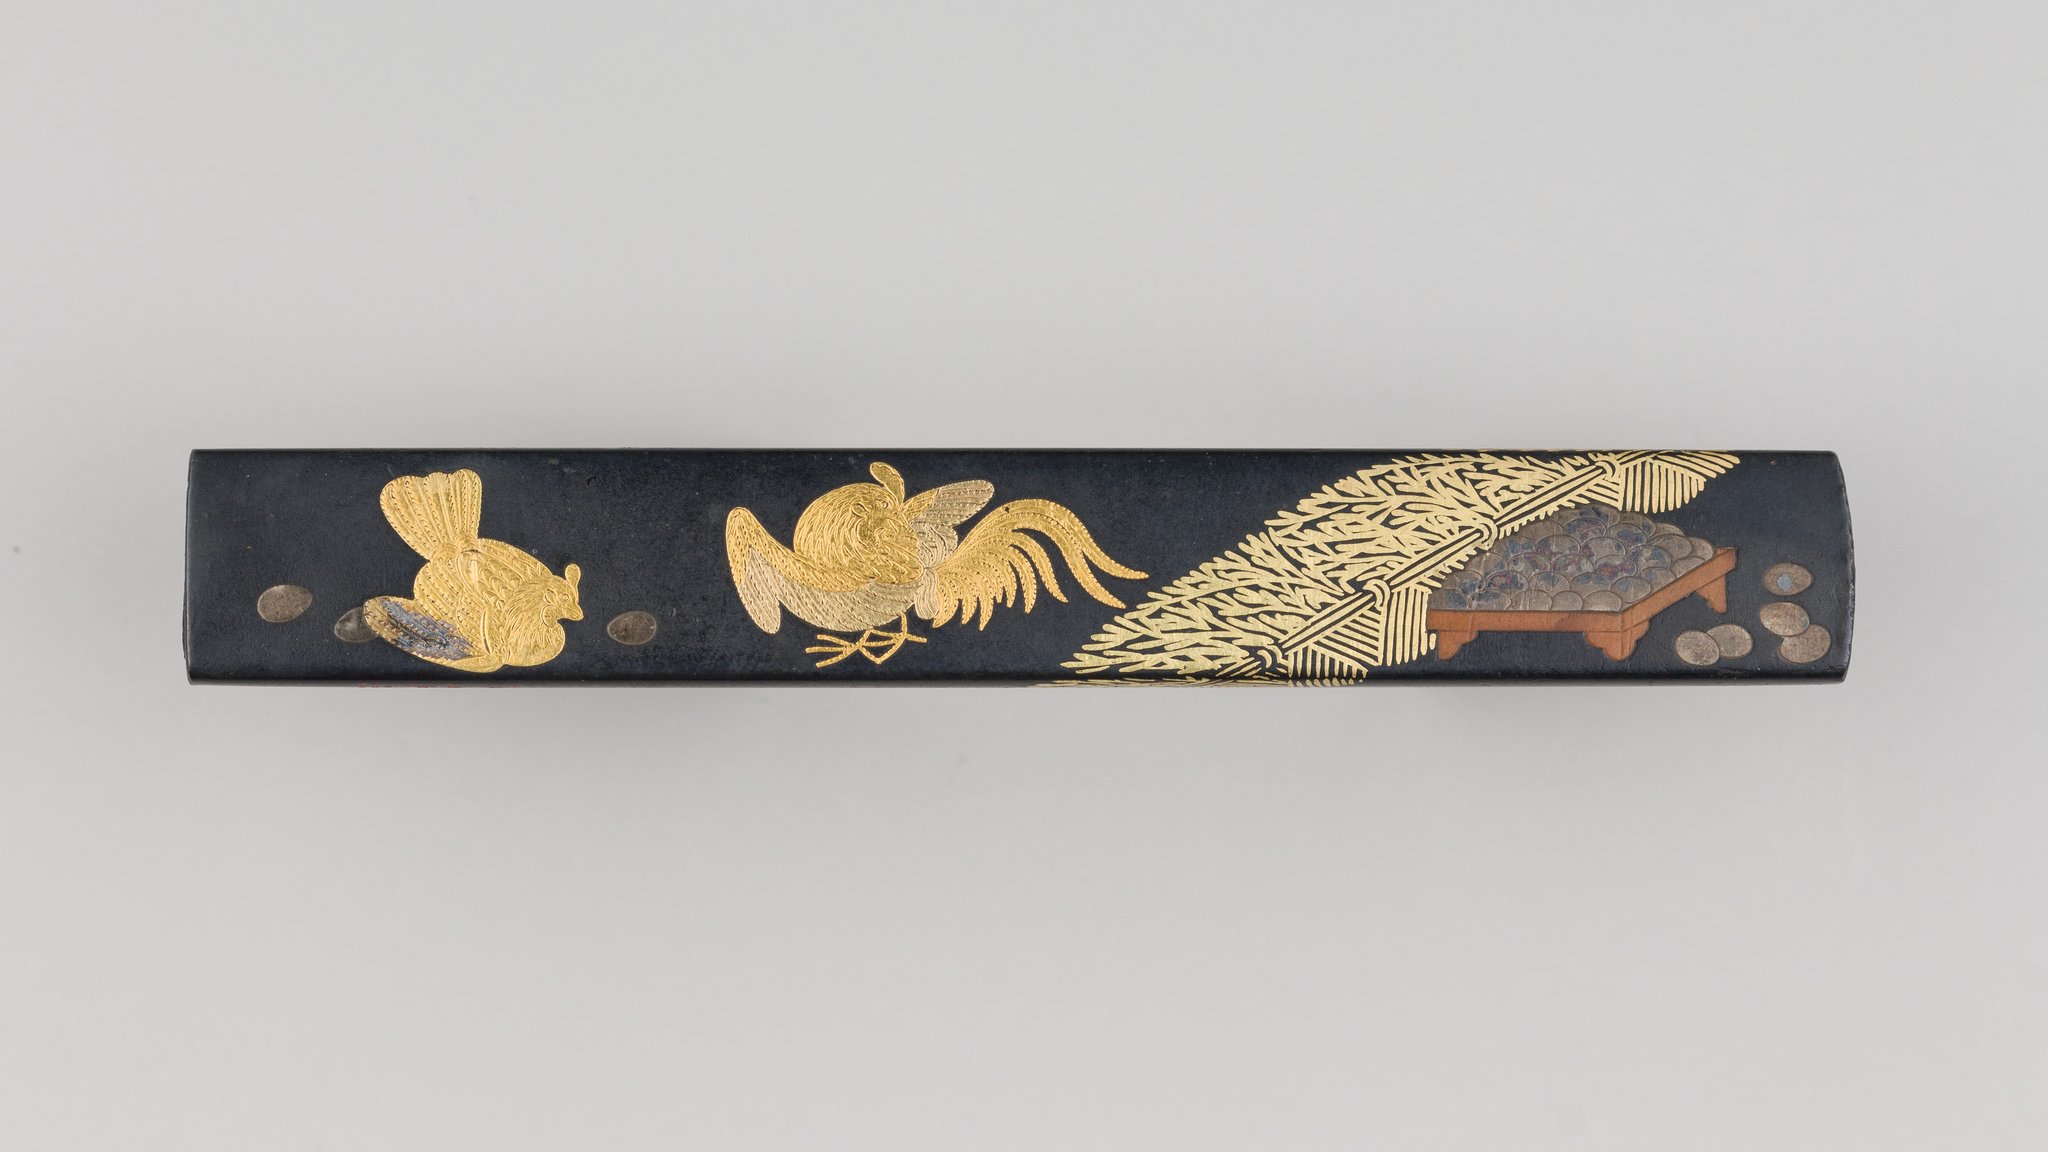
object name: knife handle kozuka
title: Knife Handle (Kozuka)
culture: japanese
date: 1701-1800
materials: copper, gold alloy, silver alloy, gold, silver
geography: japan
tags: birds